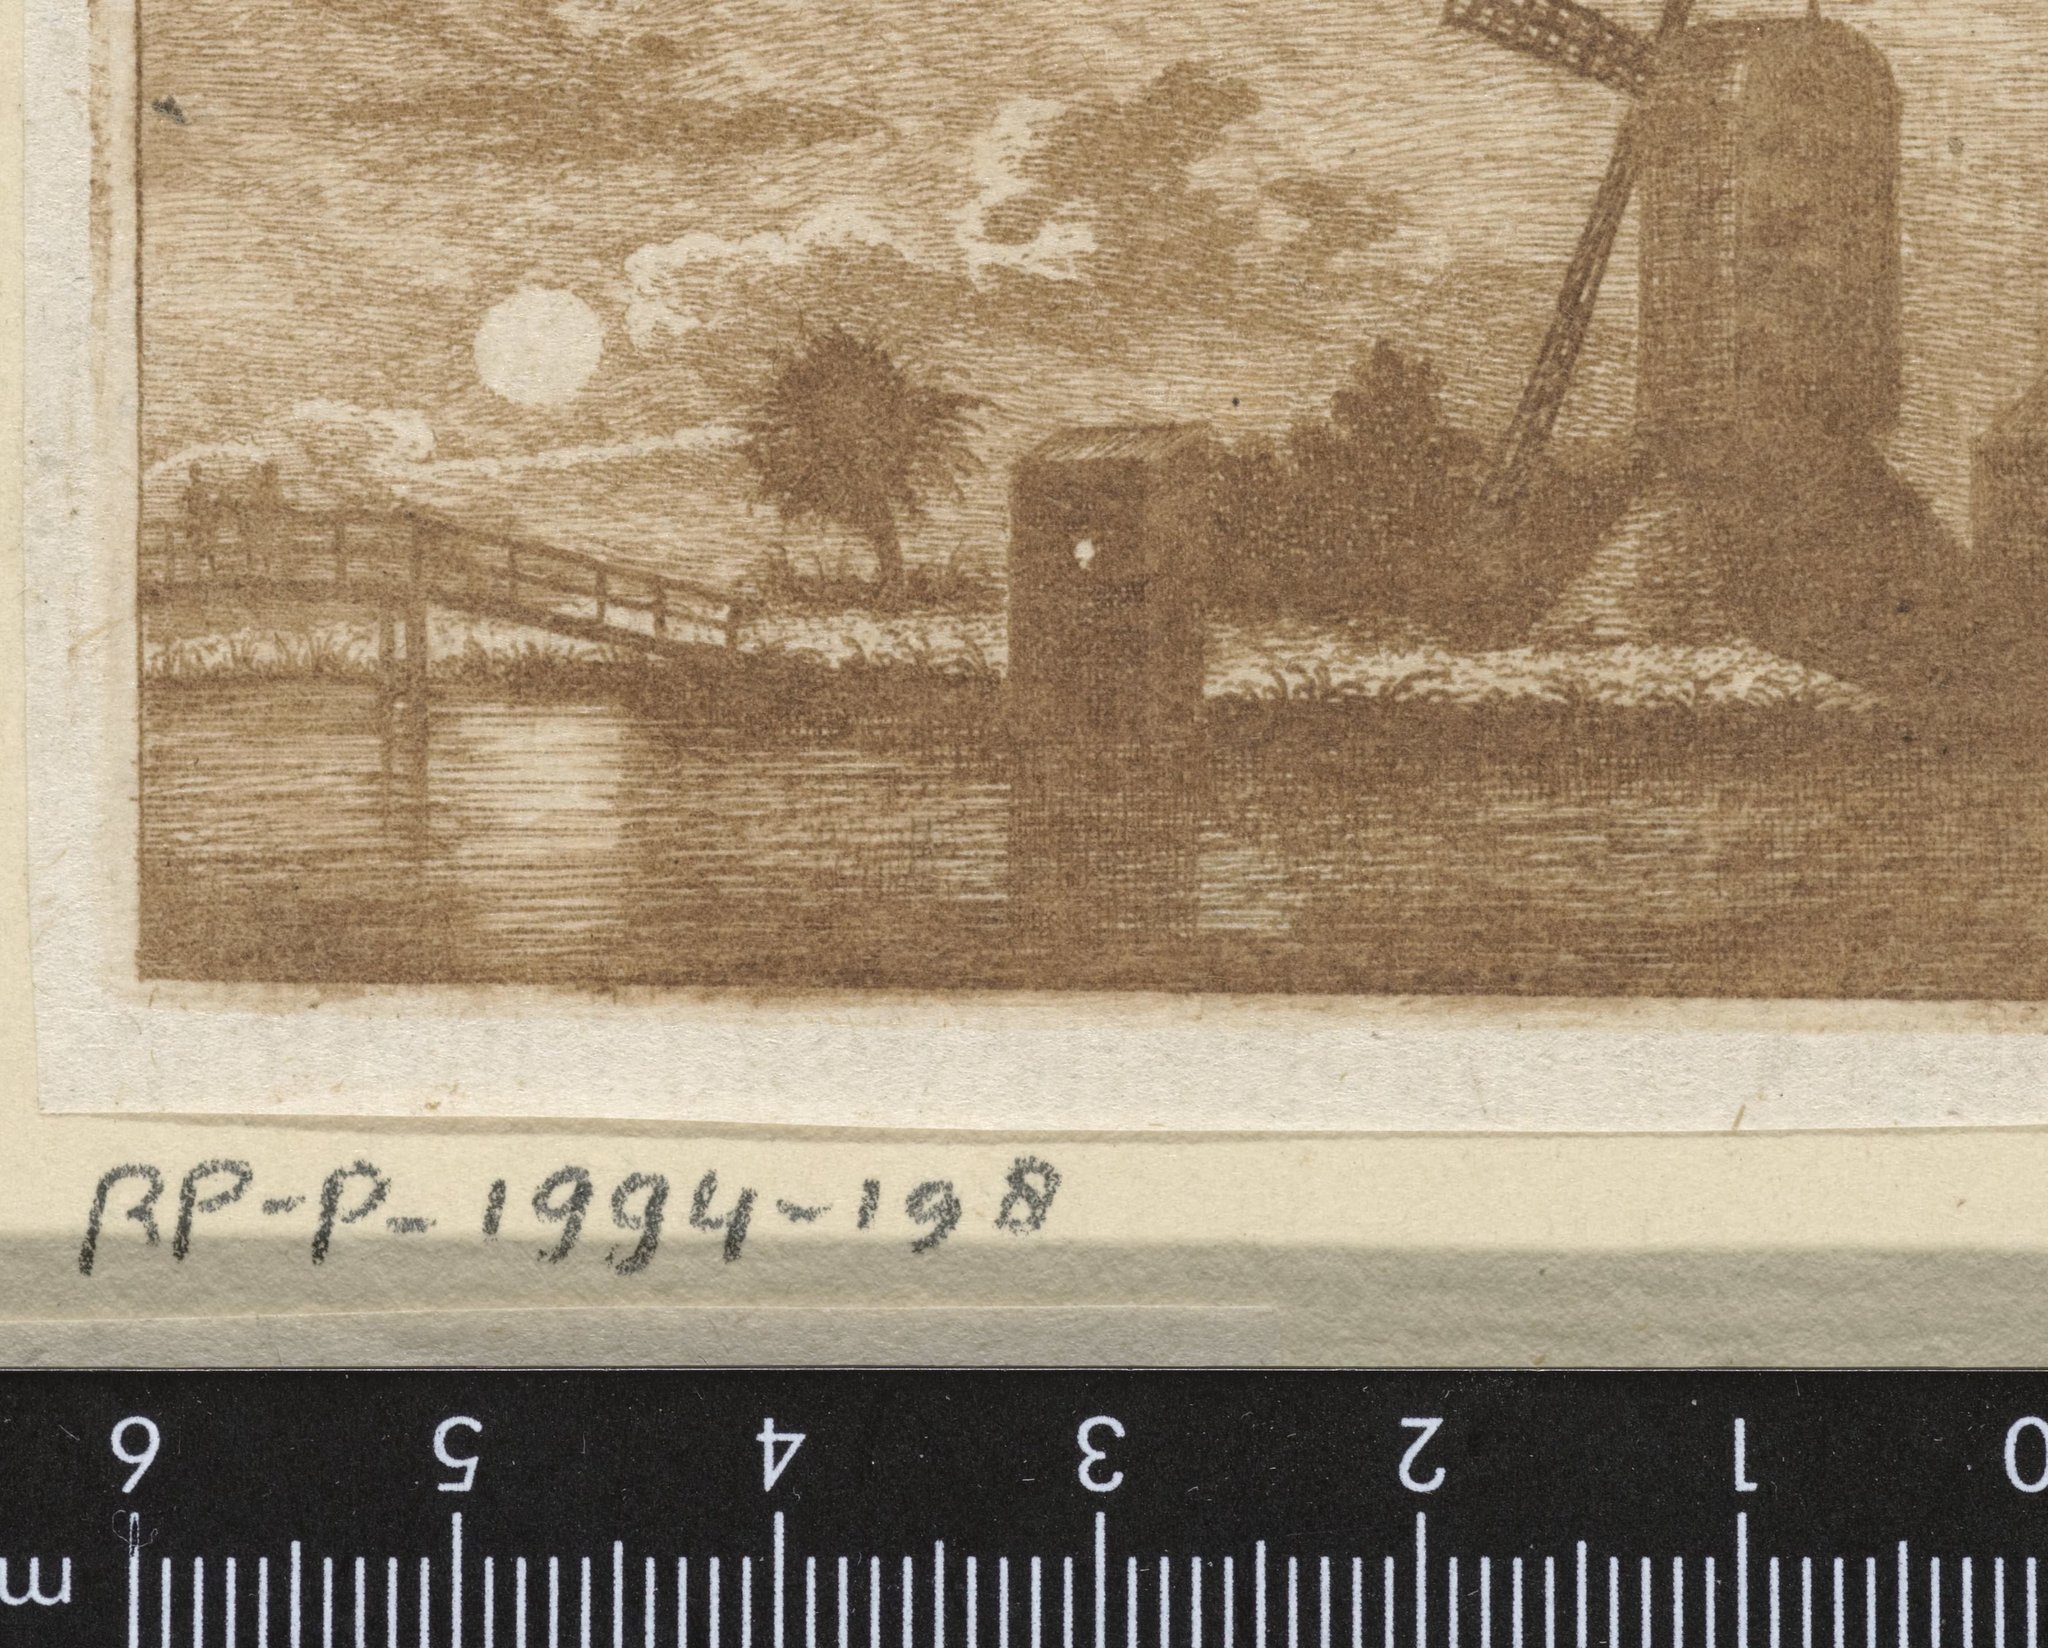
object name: print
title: Landschapjes, Rúwientjes enz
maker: caspar jacobsz. philips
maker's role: draughtsman, print maker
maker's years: 1732-1789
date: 1766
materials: paper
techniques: etching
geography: amsterdam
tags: river bank, night ~ landscape (sometimes titled 'nox'), windmill